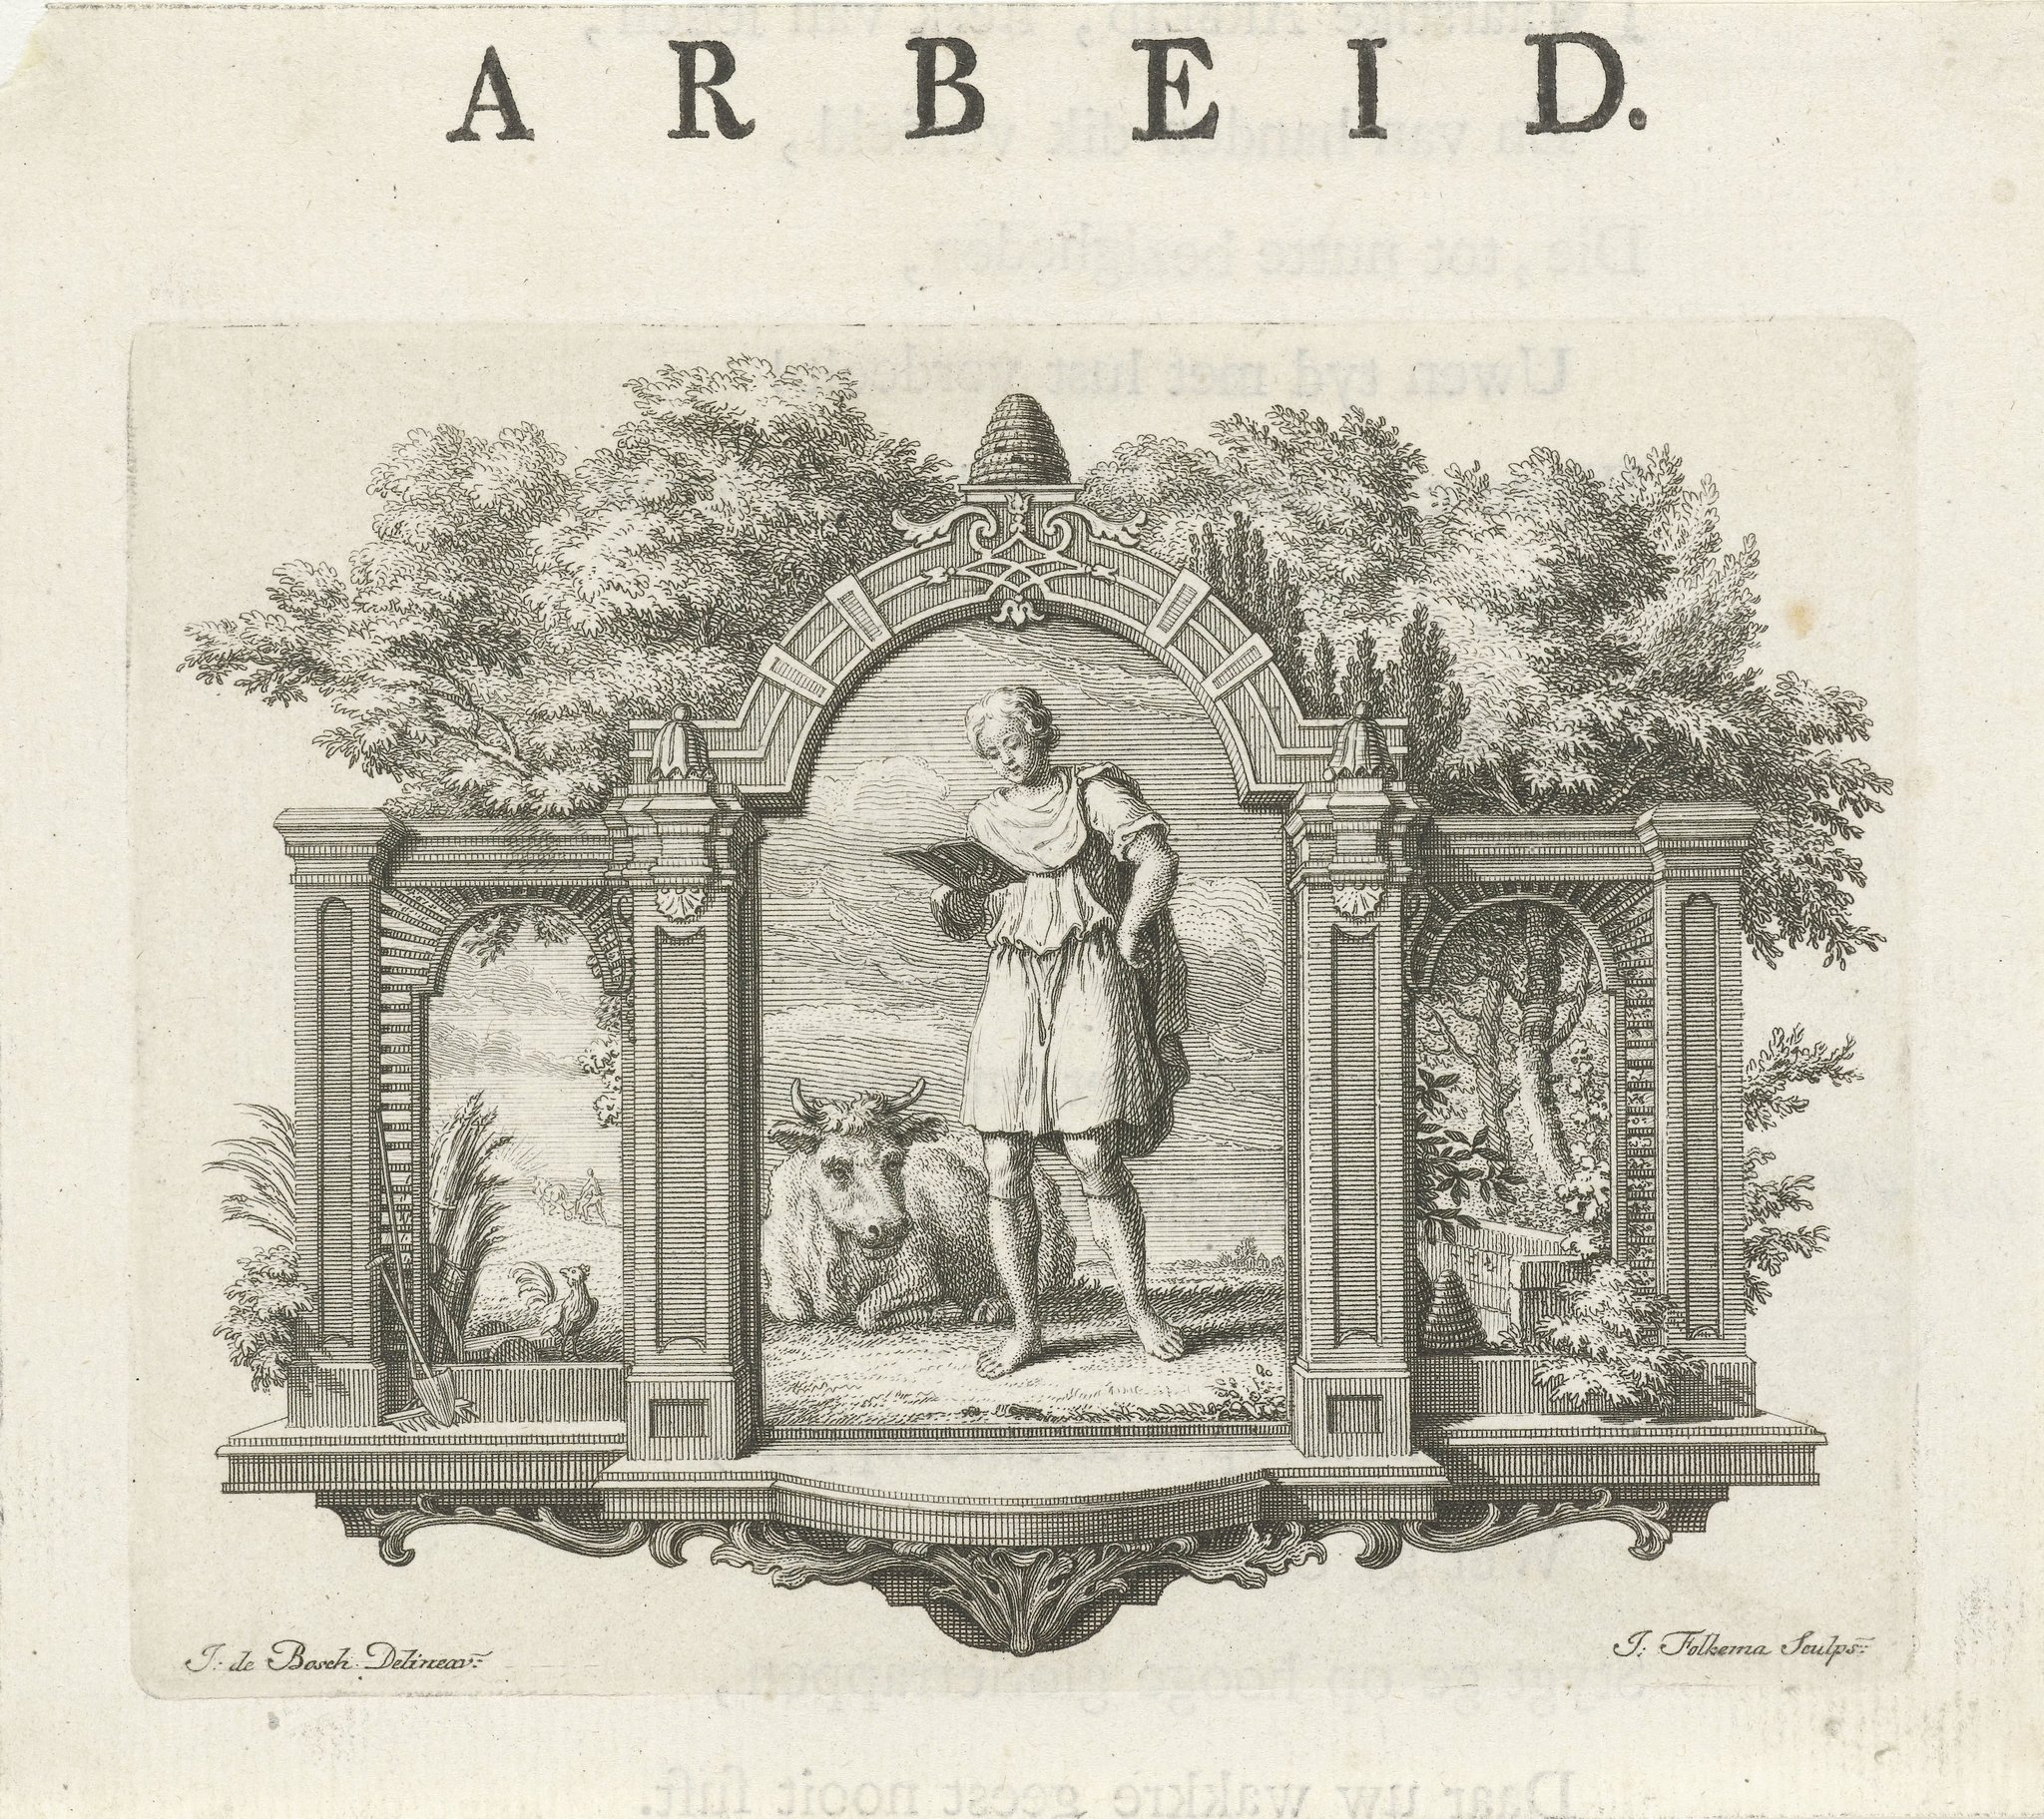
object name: print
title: Arbeid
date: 1723-1767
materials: paper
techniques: etching, letterpress printing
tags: fruitfulness, productiveness, fertility, fecundity; 'fecondità' (ripa)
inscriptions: collector's mark: Lugt 2228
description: Vignet met de beeltenis van de gepersonifieerde Arbeid in een architecturale omlijsting dat getooid is met een bijenkorf. De Arbeid leest een boek, achter hem ligt een rund in het gras. De prent maakt deel uit van een reeks boekillustraties over deugden en ondeugden.